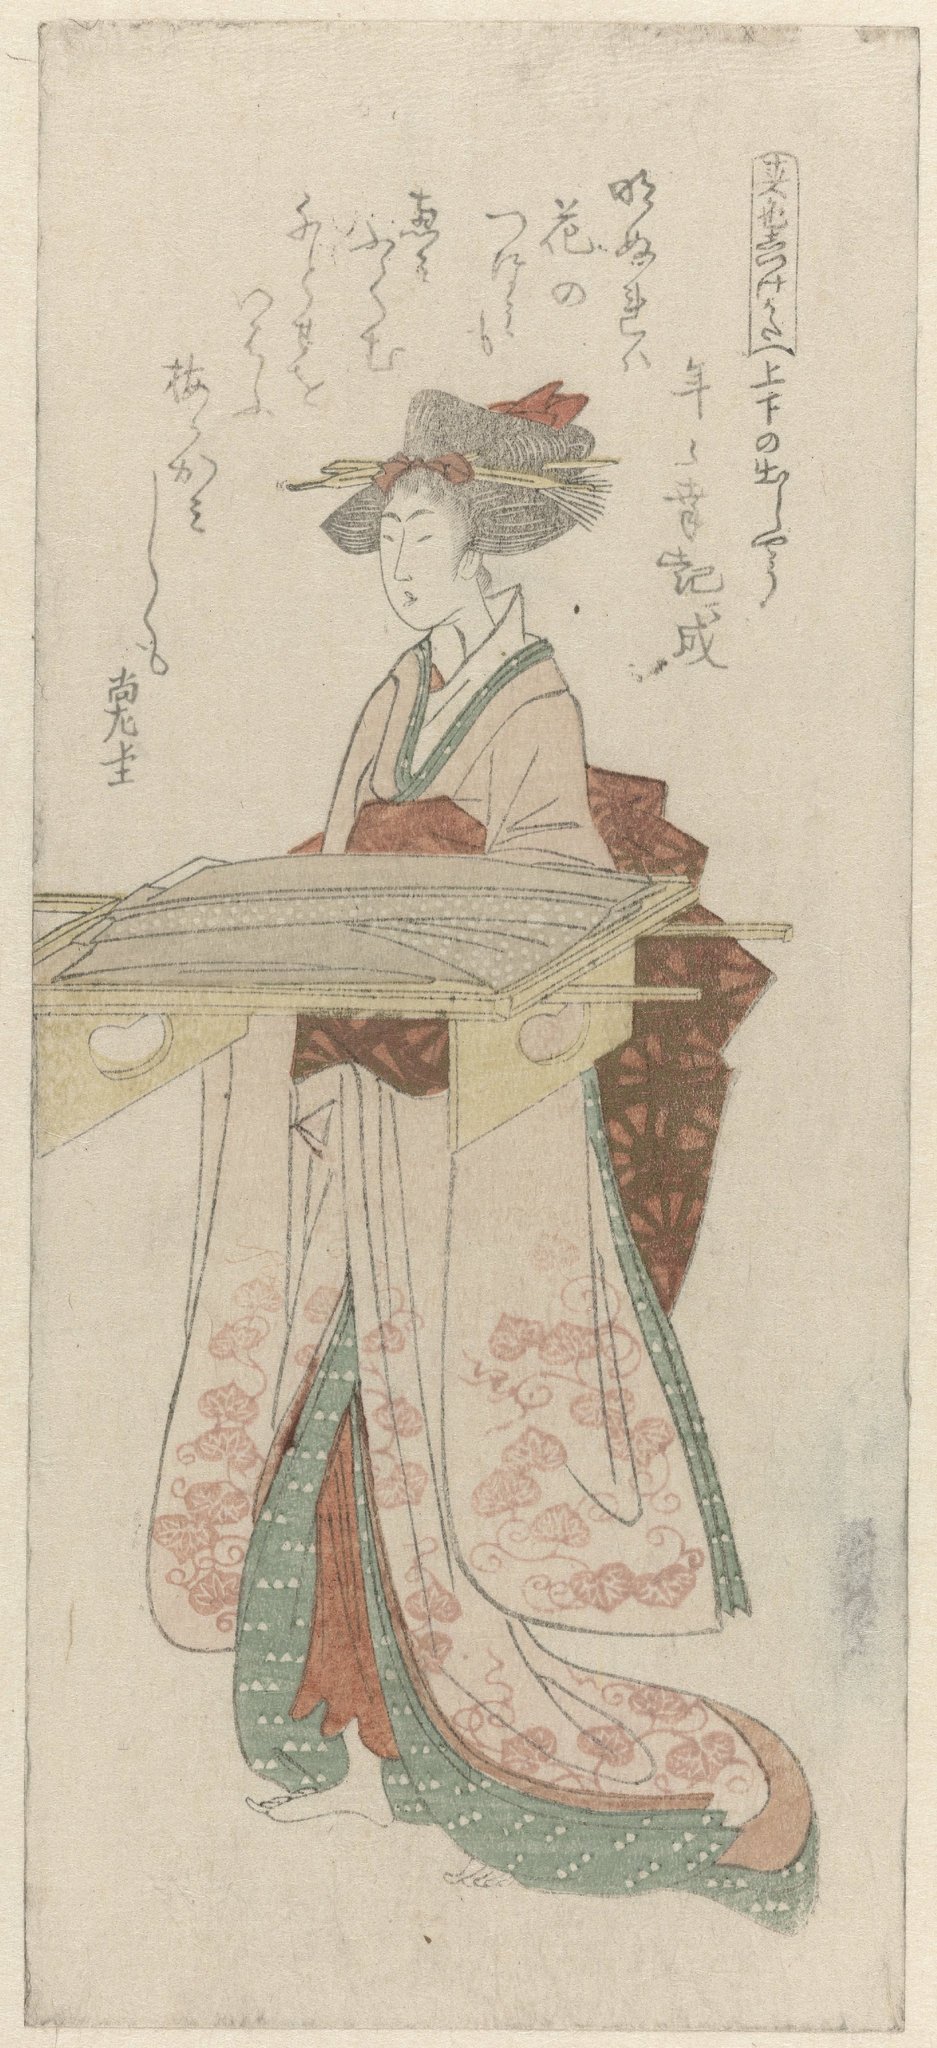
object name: surimono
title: Woman Holding a Tray with Clothing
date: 1807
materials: paper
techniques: blind stamped, woodcut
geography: japan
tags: adult woman, clothes, costume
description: Een surimono is een luxe uitgevoerde prent waarop beeld met één of meerdere gedichten gecombineerd is. Bij het drukken van een surimono werd vaak gebruik gemaakt van dikker papier, blinddruk en metaal pigmenten, zoals koper- en zilverpoeder. De prenten werden vaak in opdracht van dichters gemaakt en als exclusief geschenk aan vrienden en relaties gegeven.